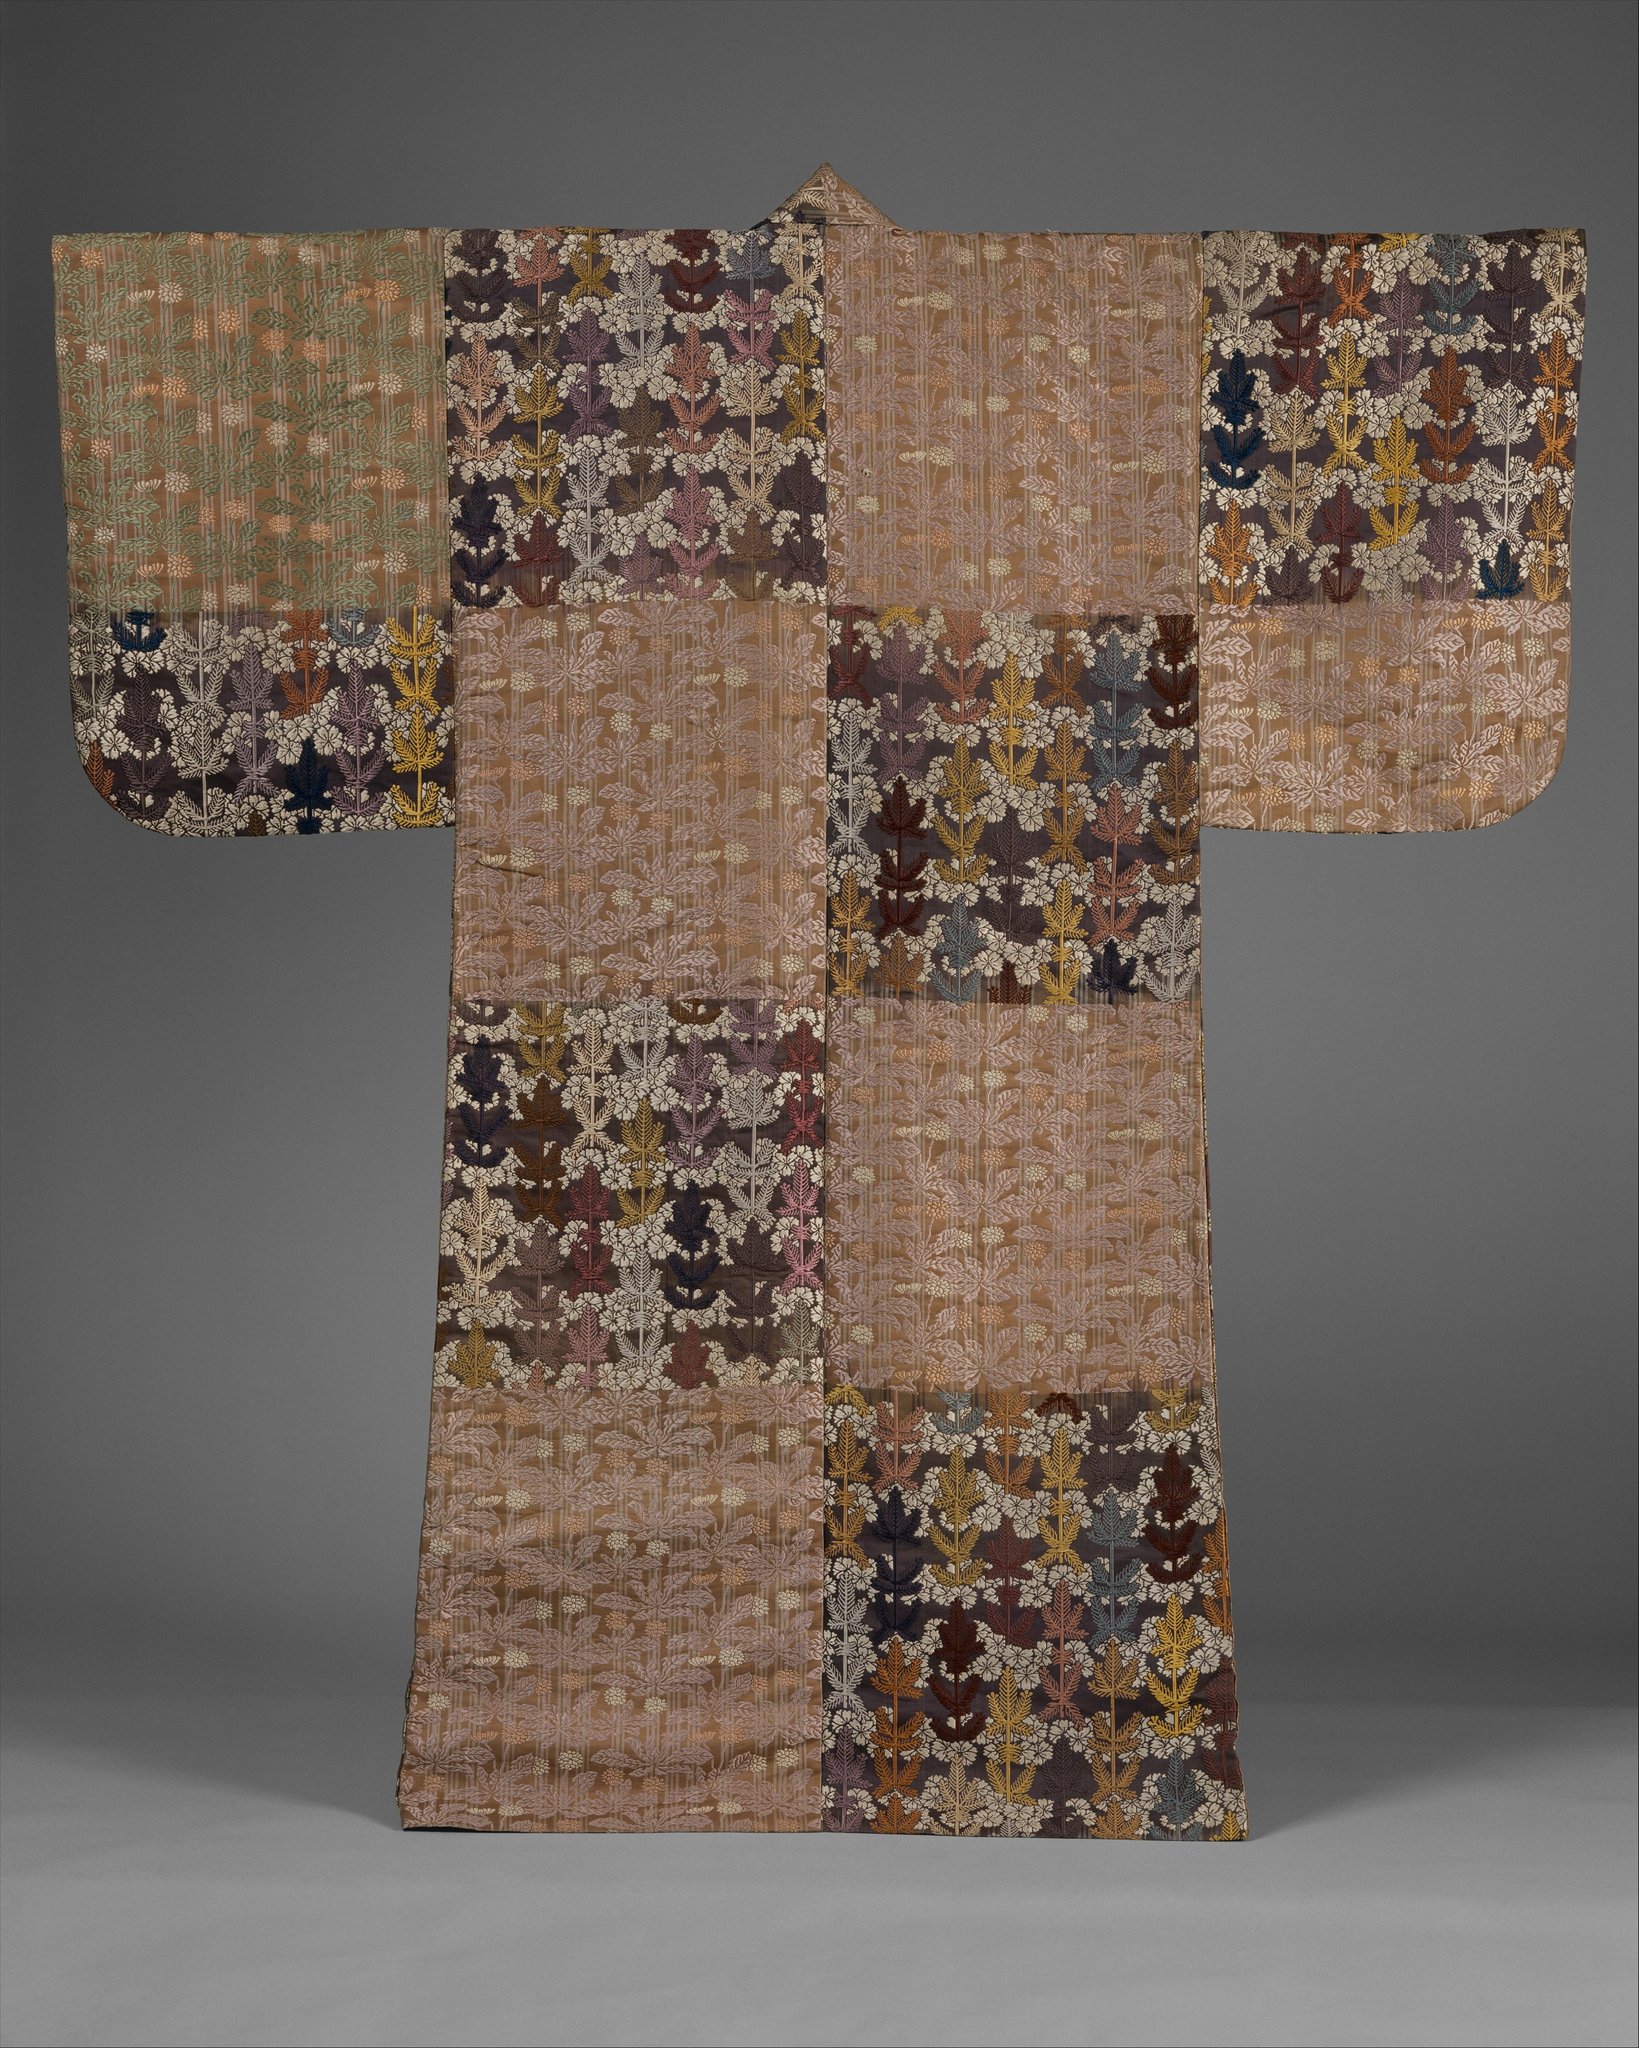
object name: noh robe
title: Noh Robe (Atsuita) with Young Pines, Cherry Blossoms, and Dandelions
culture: japanese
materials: silk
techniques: brocade, weave